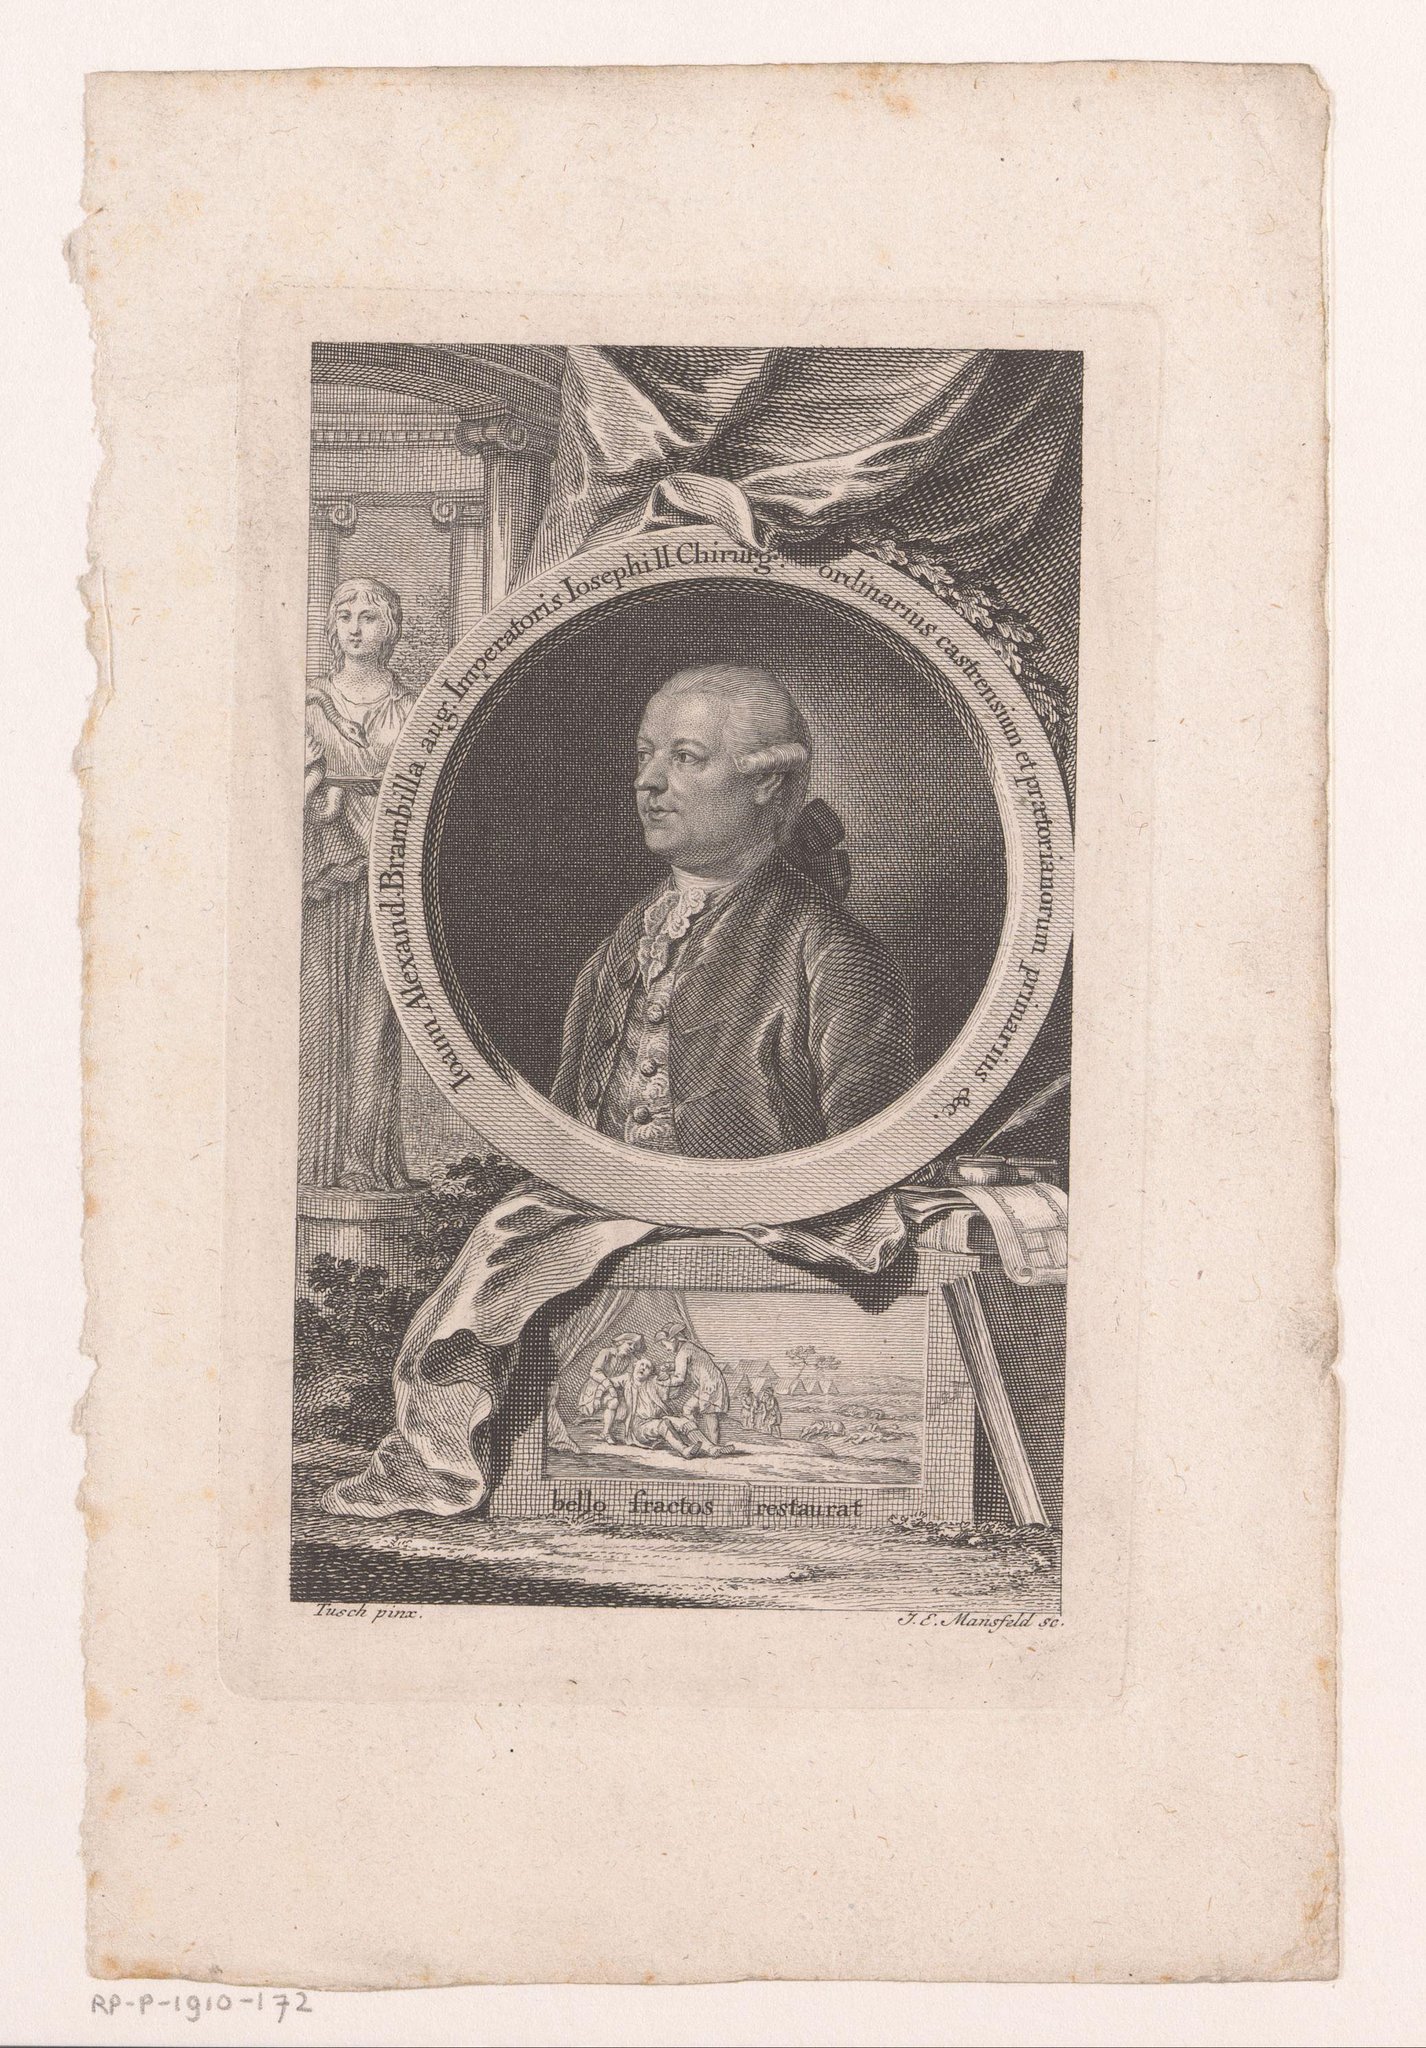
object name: print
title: Portret van Johann Alexander Brambilla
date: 1749-1796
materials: paper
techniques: engraving, etching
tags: historical persons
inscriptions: collector's mark: Lugt 2228